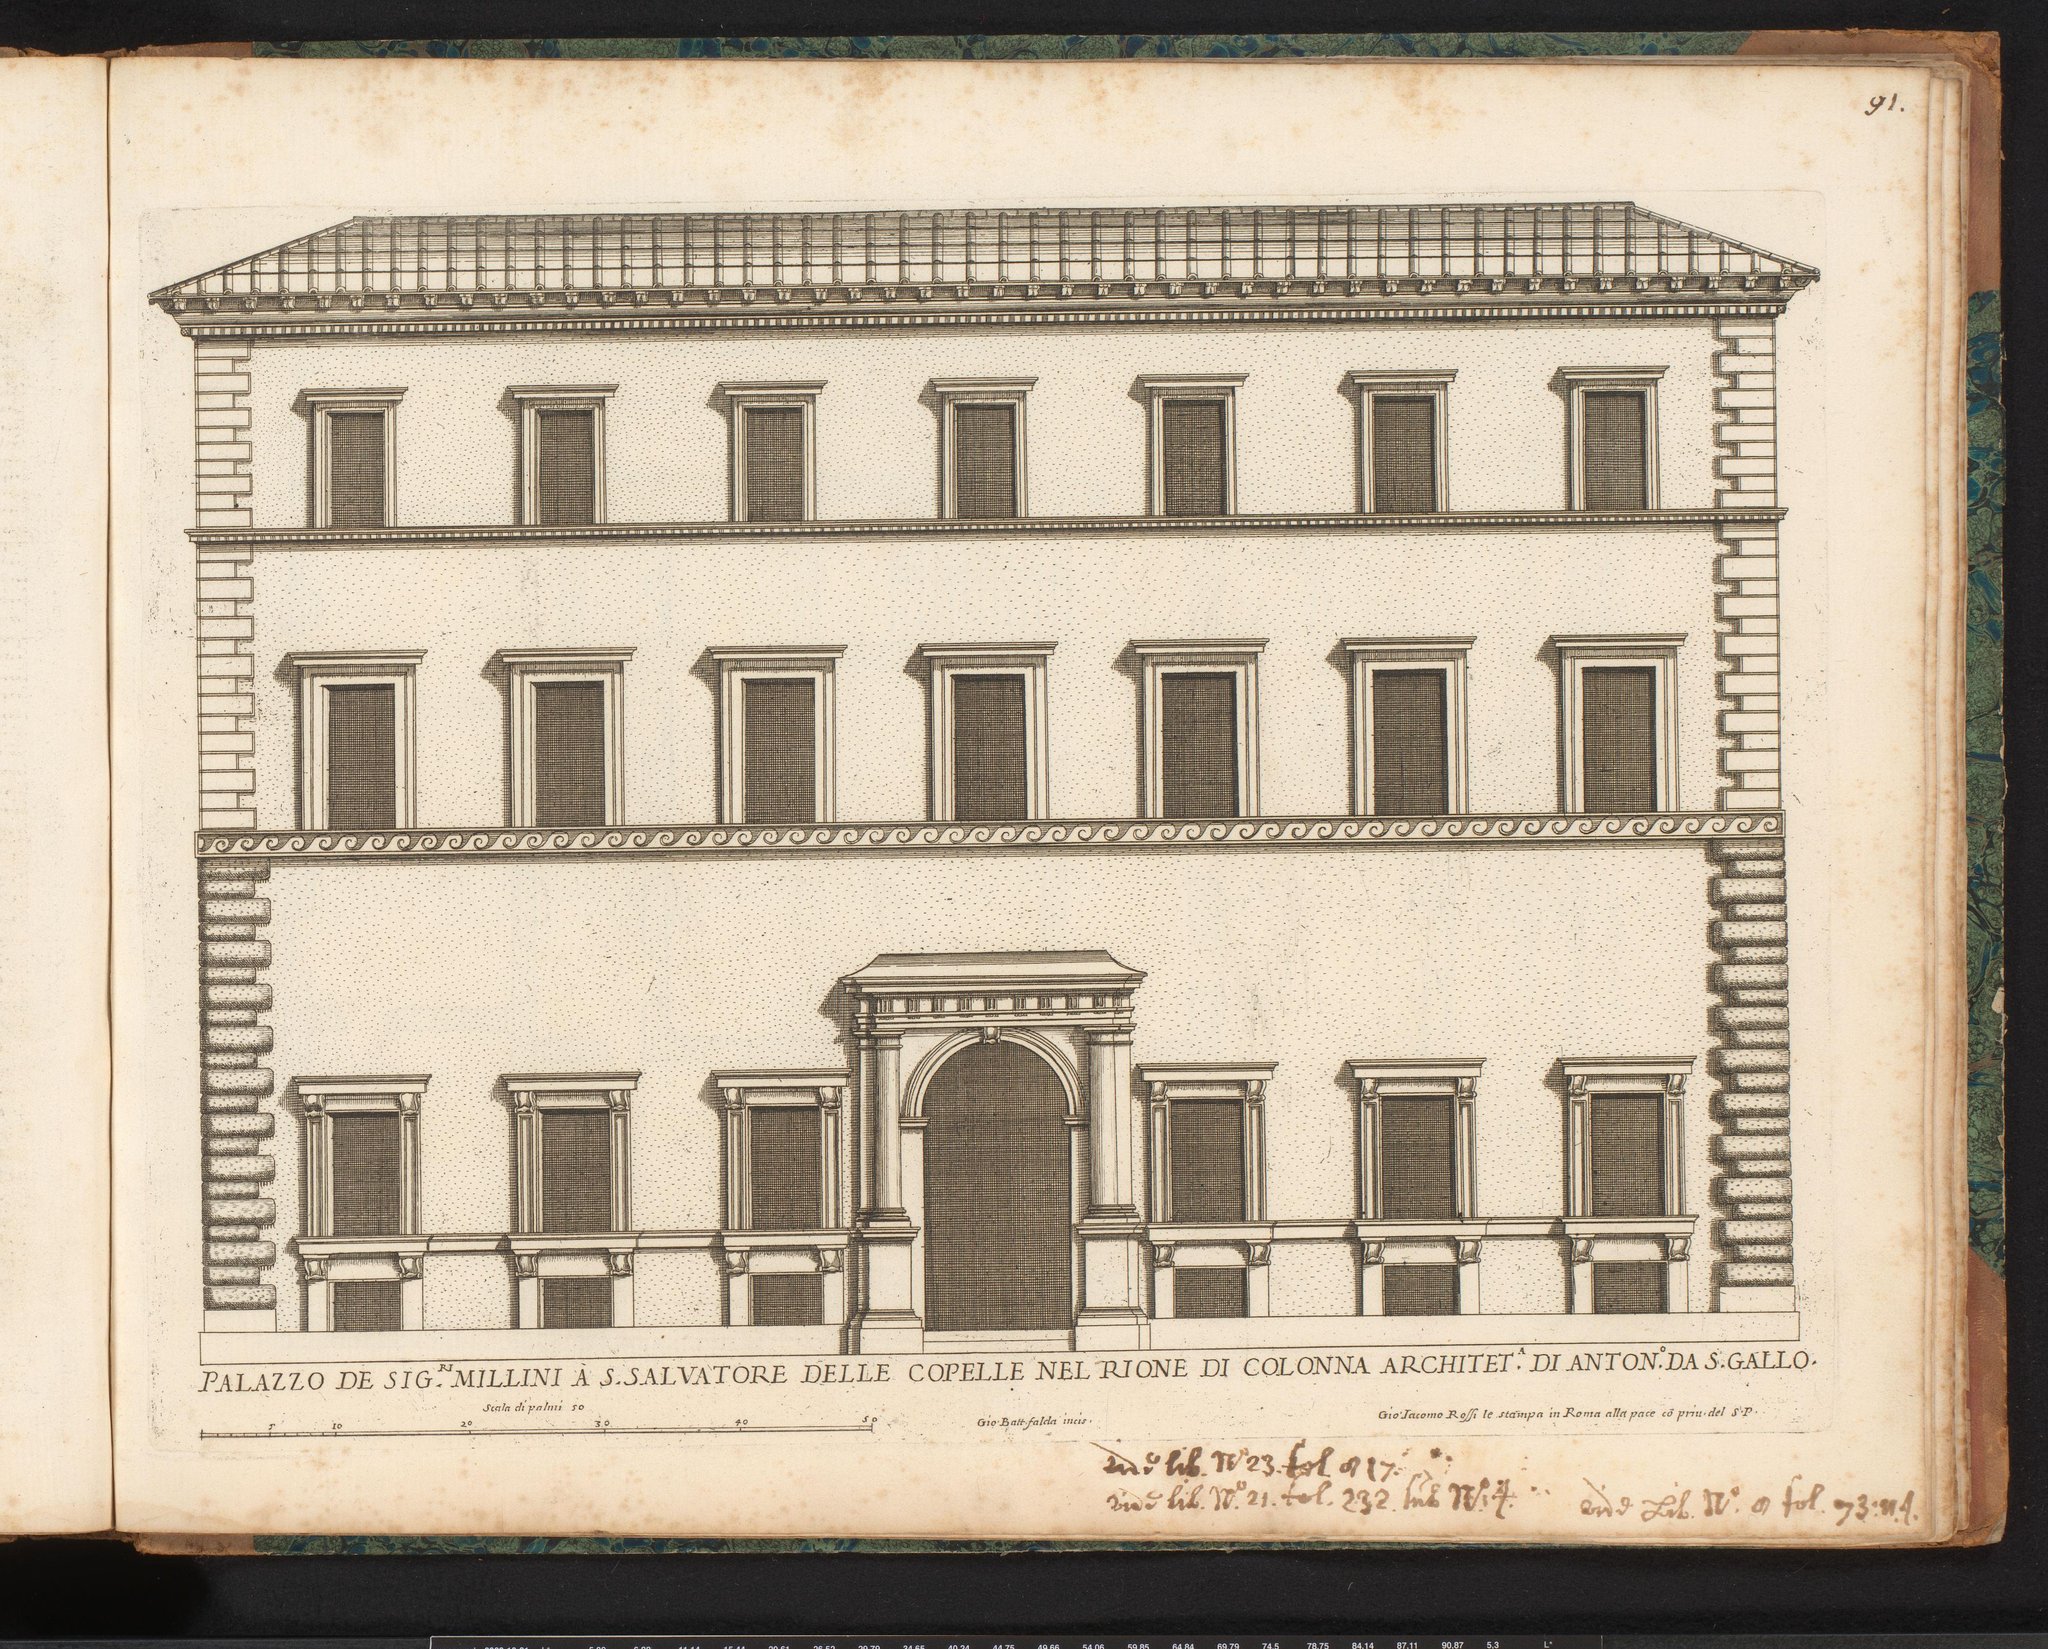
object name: print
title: Façade van Palazzo Millini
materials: paper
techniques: etching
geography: italy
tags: palace, façade (of house or building)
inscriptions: inscription: ‘Ende lib. No. 23. fol. 817./ Ende lib. No. 21. fol. 232. lib. No. 14./ Ende lib. No. 8. fol. 73. n. 4.’, number: ‘91’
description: Deze prent maakt deel uit van de reeks getiteld: Palazzi di Roma. Deze reeks bestaat uit twee boeken. Boek één getiteld: Palazzi di Roma dei più celebri architetti..., bestaat uit 44 prenten die worden toegeschreven aan Giovanni Battista Falda (naam staat enkel op prent 27) en uitgegeven door Giovanni Giacomo de'Rossi. Deze 44 prenten zijn bekend in twee staten (met en zonder nummer). Boek twee getiteld: Nuovi disegni dell'architetture... libro secondo, bevat 66 prenten door Giovanni Battista Falda en Simone Felice. Deze 66 prenten zijn bekend in twee staten (met en zonder nummer).